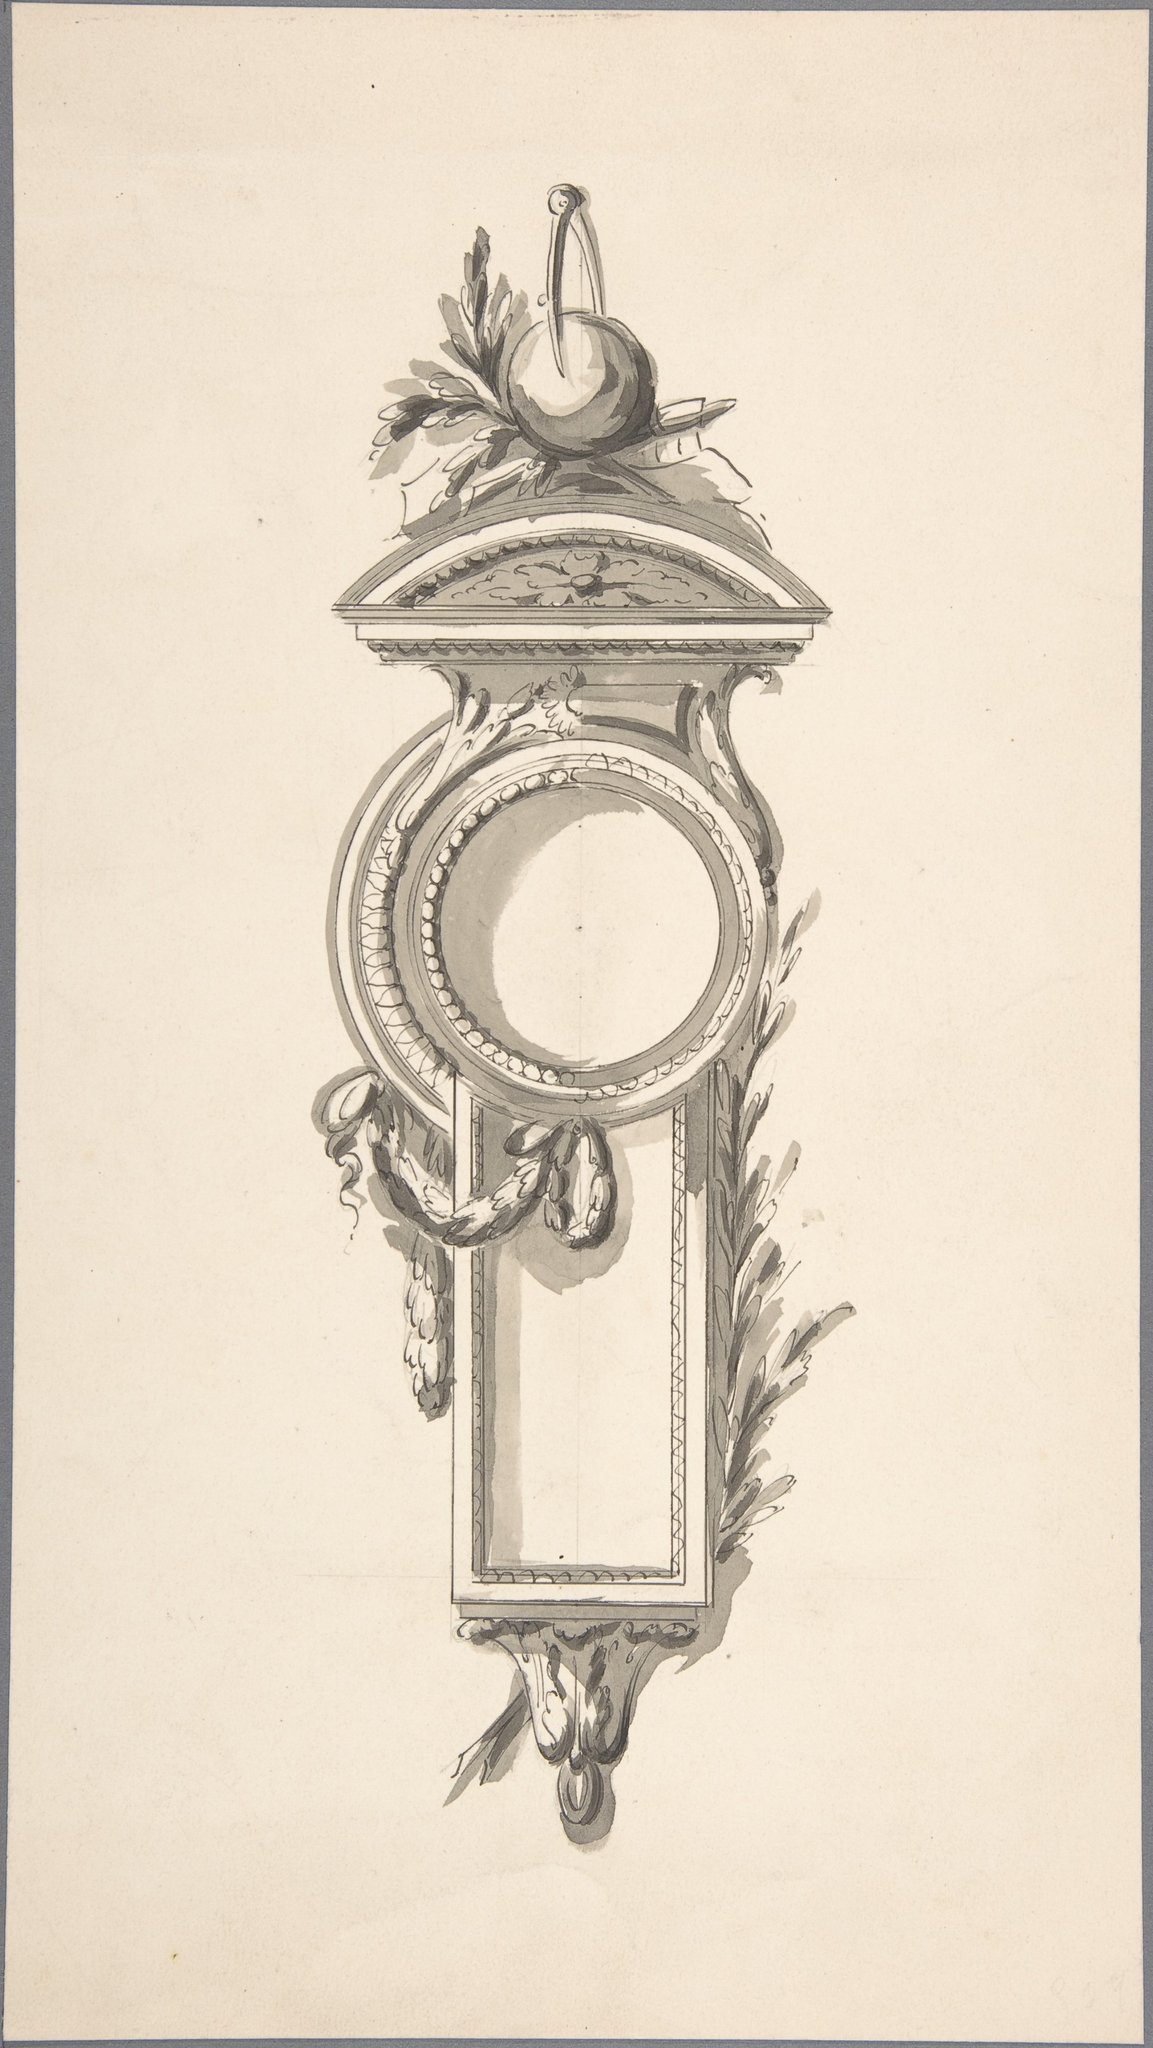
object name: drawing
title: Design for a Clock Case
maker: anonymous, french, 18th century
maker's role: artist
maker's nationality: french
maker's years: 1700-1800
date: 1770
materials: graphite, ink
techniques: brush, pen, wash